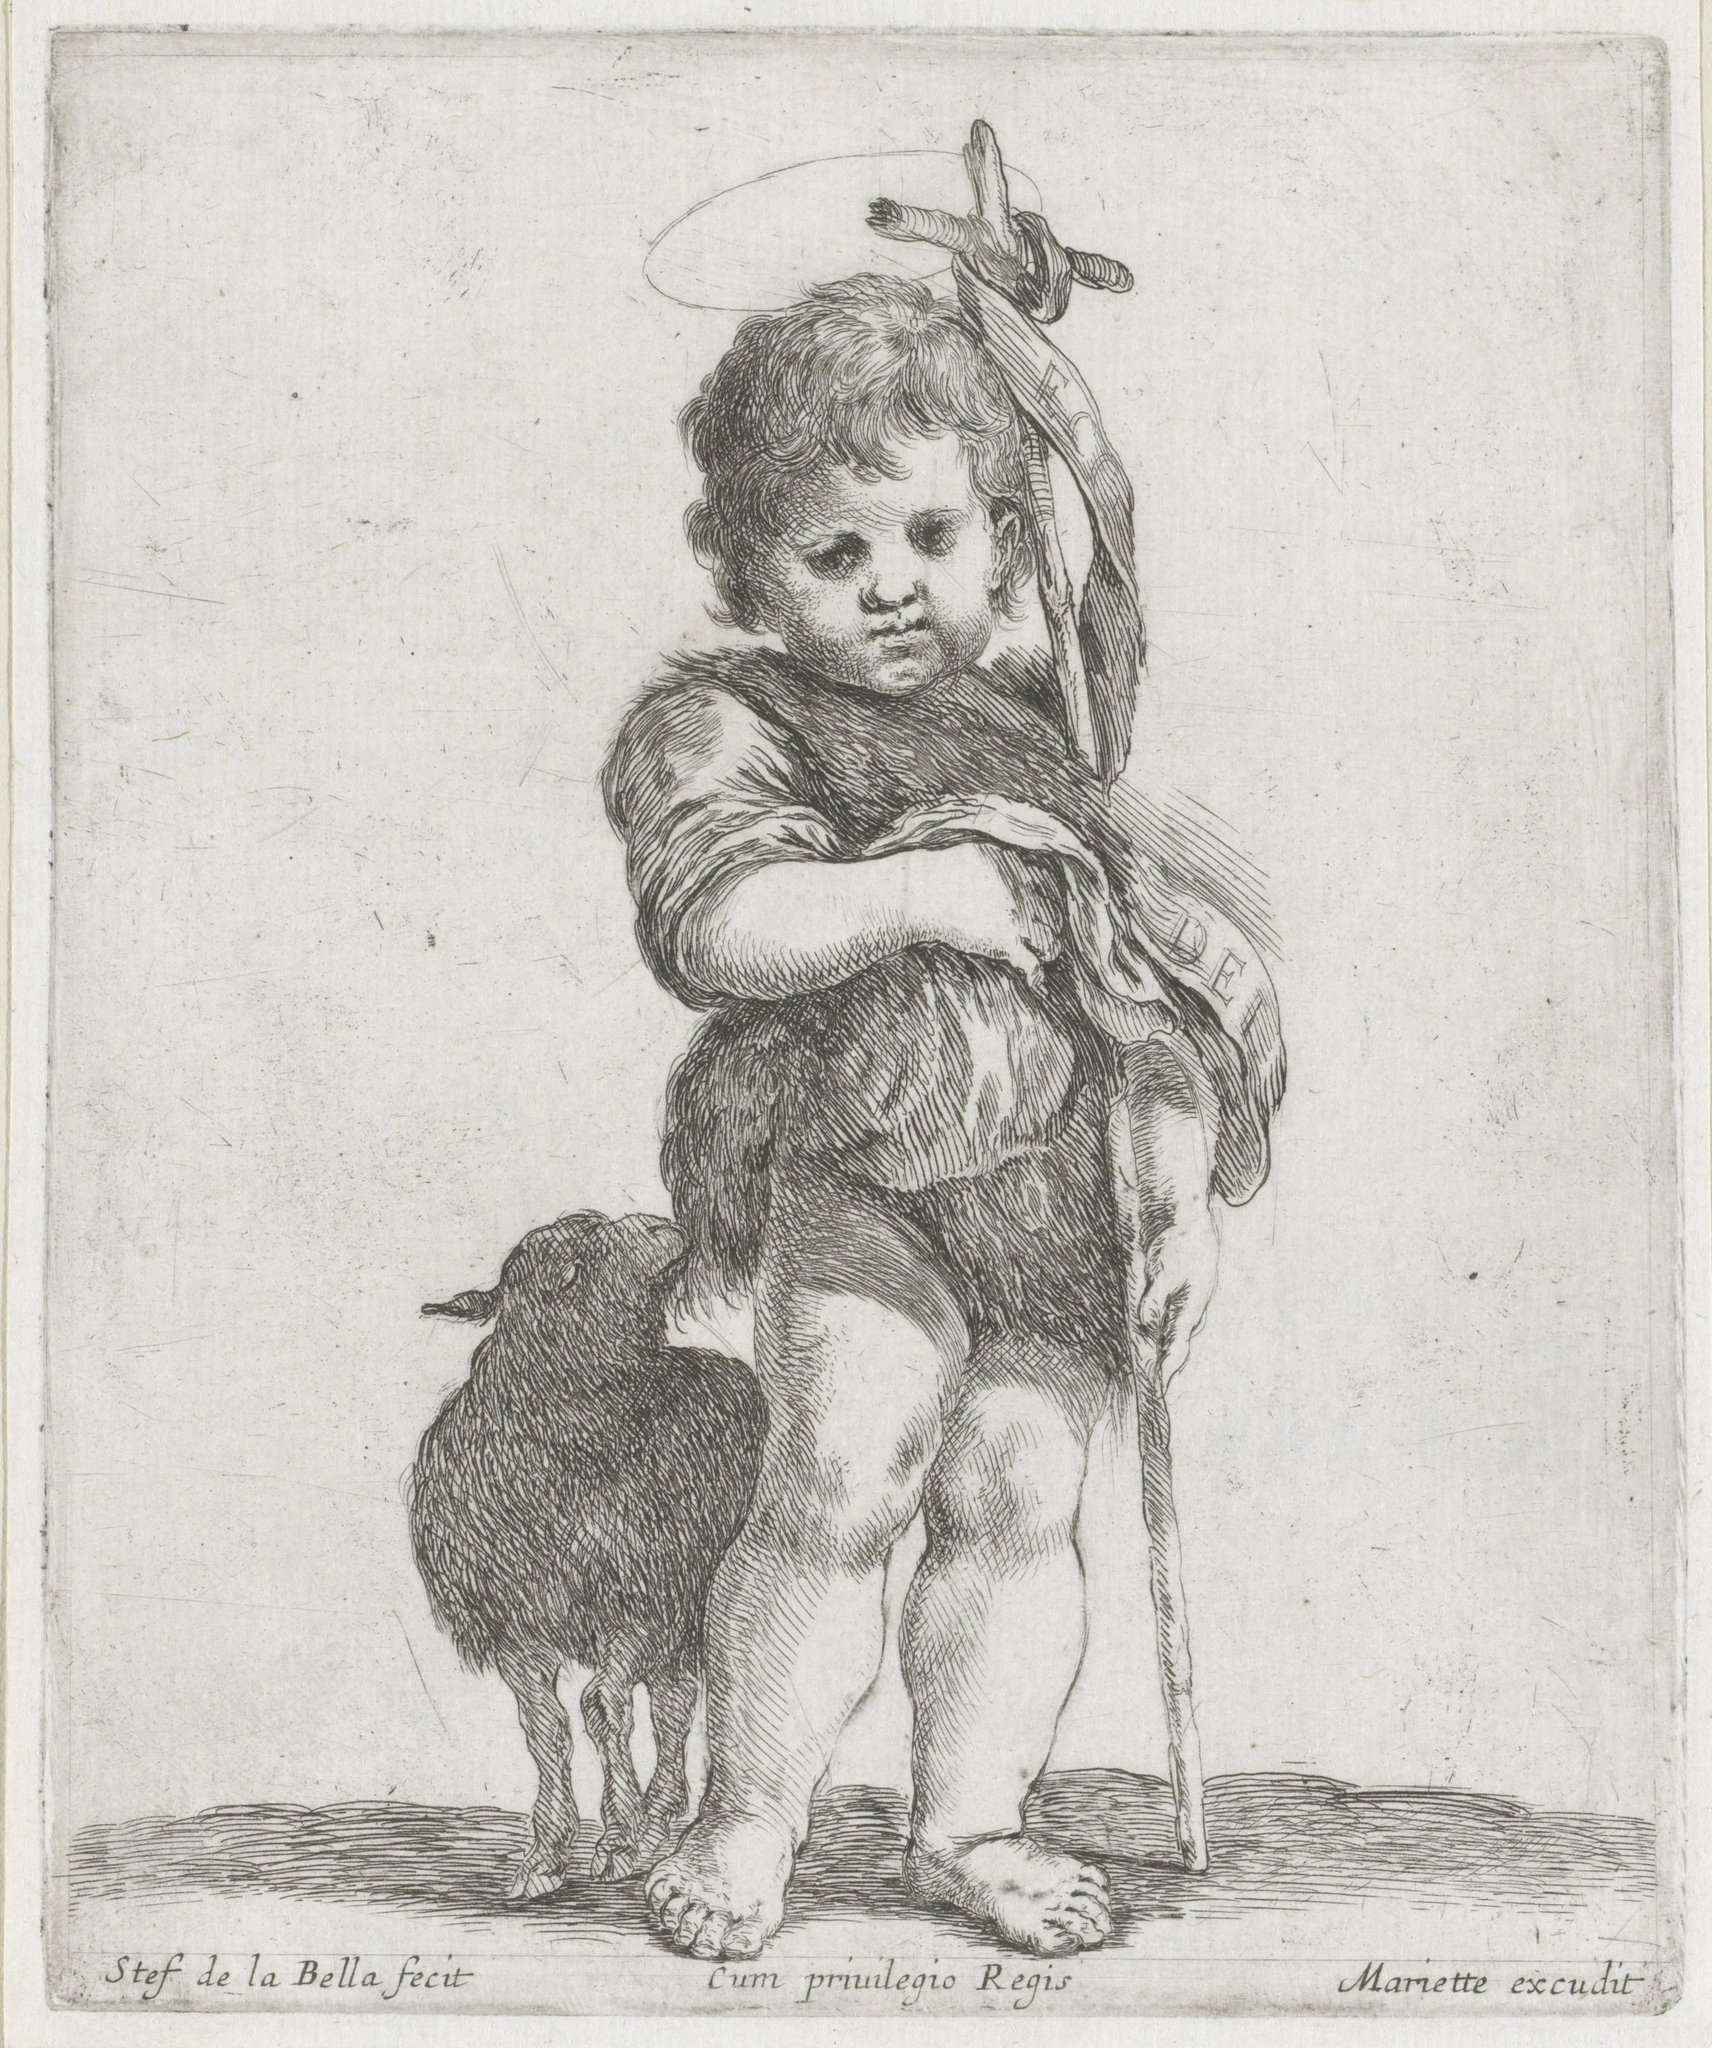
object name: print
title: Johannes de Doper als kind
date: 1620-1664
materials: paper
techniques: etching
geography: italy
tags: john the baptist; possible attributes: book, reed cross, baptismal cup, honeycomb, lamb, staff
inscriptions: collector's mark: Lugt 240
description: De jonge Johannes de Doper met in zijn linker hand zijn kruisstaf. Naast hem staat zijn lam.